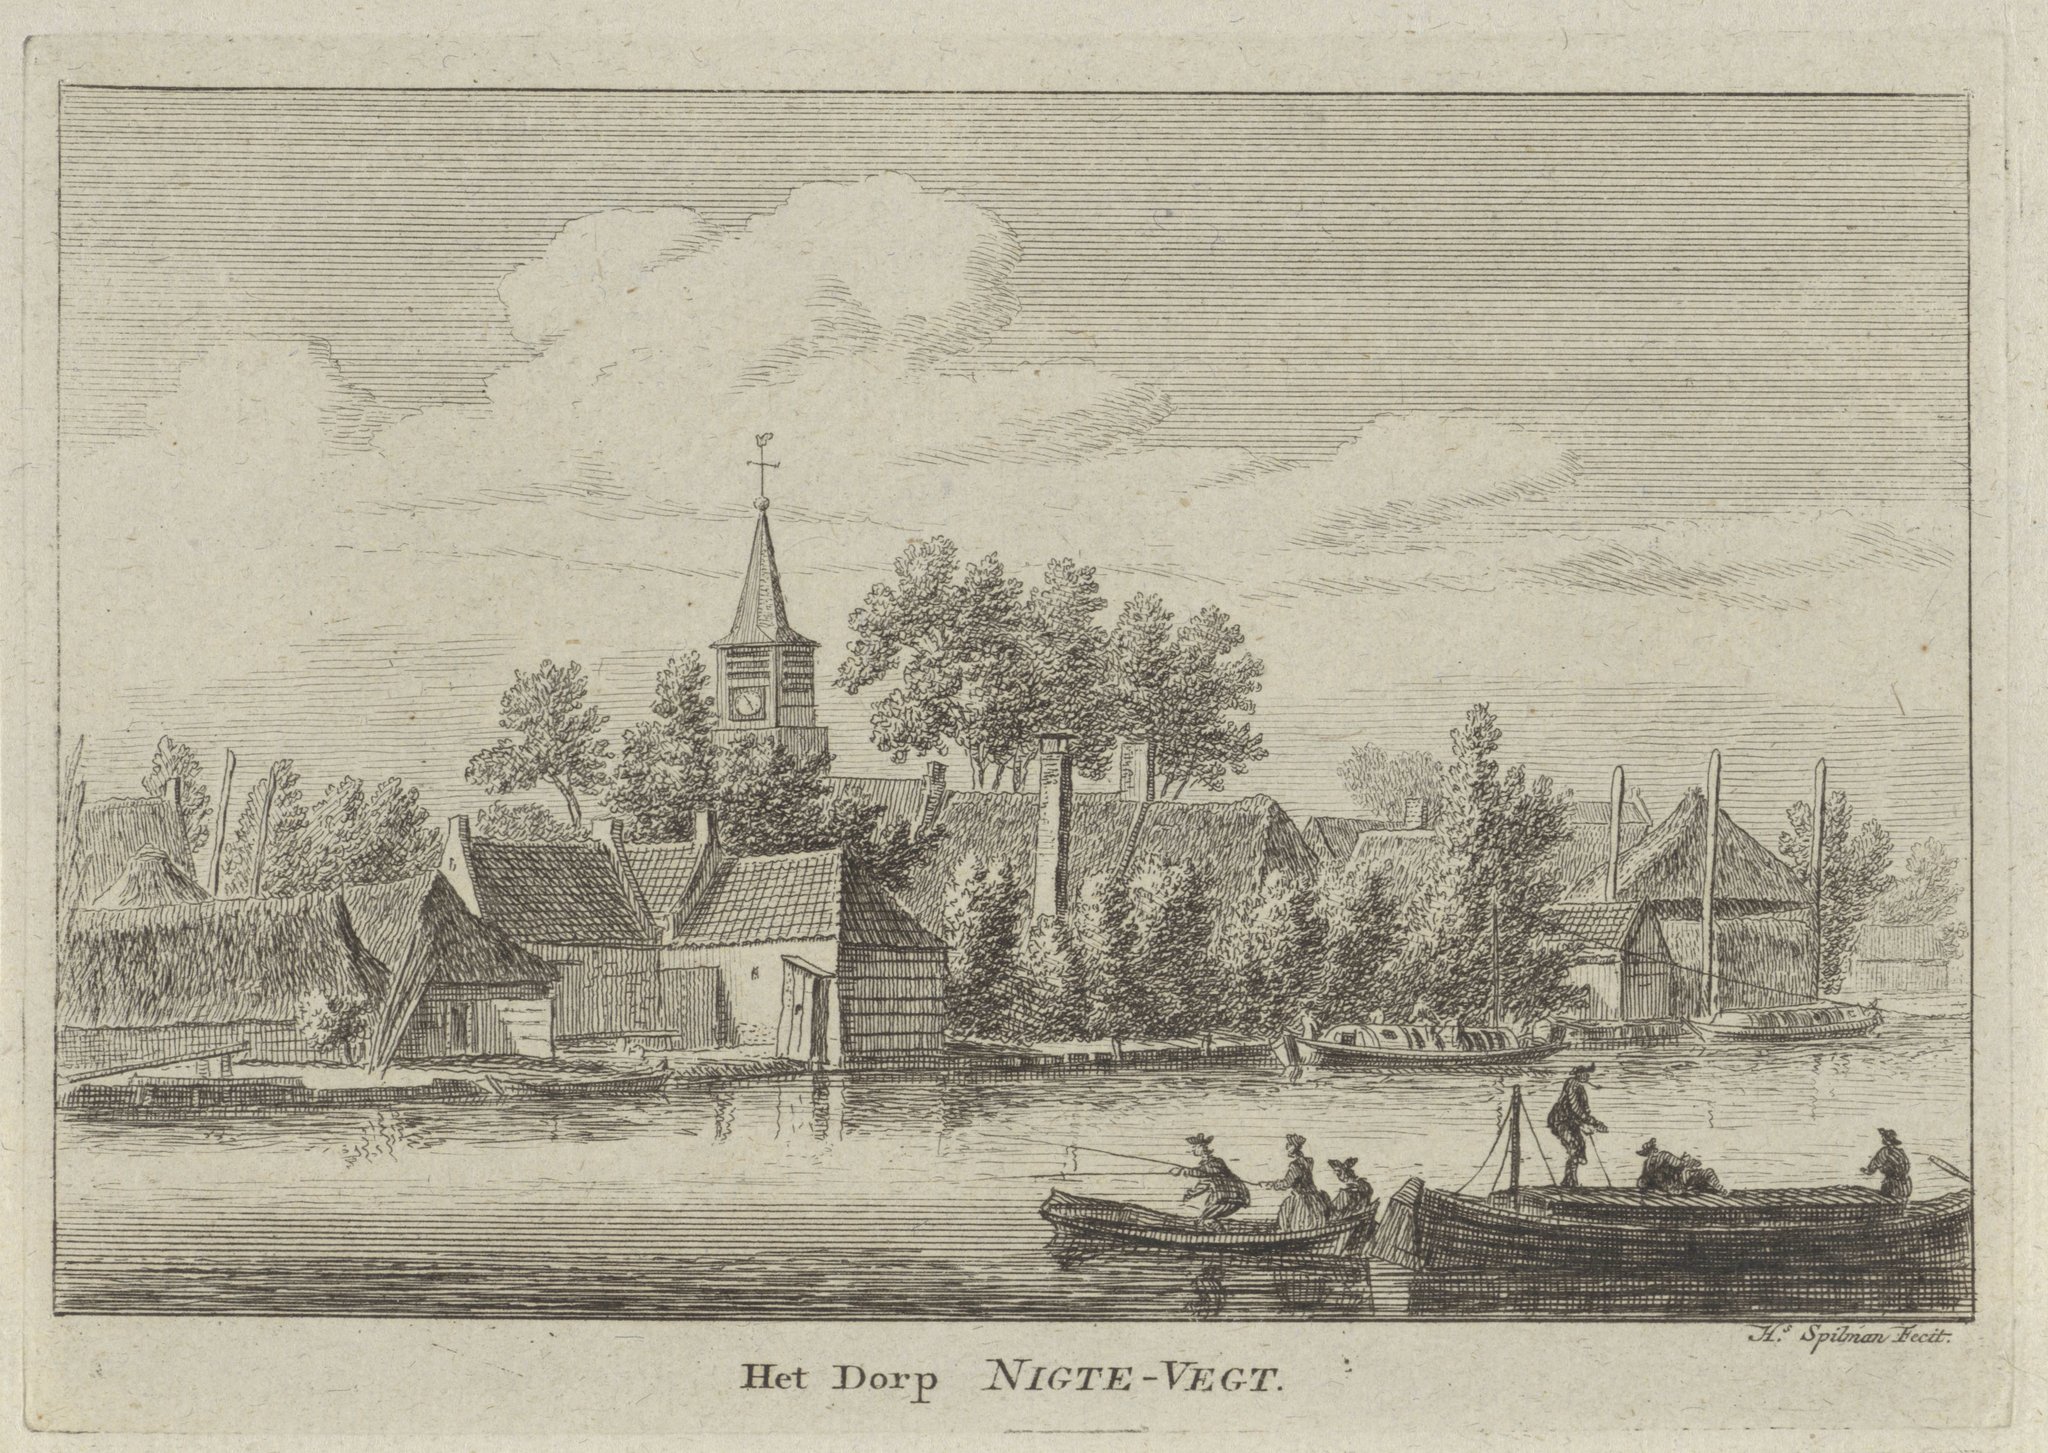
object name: print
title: Het Dorp Nigte-Vegt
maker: hendrik spilman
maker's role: draughtsman, painter, print maker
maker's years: 1721-1784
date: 1742-1784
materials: paper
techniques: etching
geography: haarlem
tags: river, church (exterior), angling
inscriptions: collector's mark: Lugt 2228